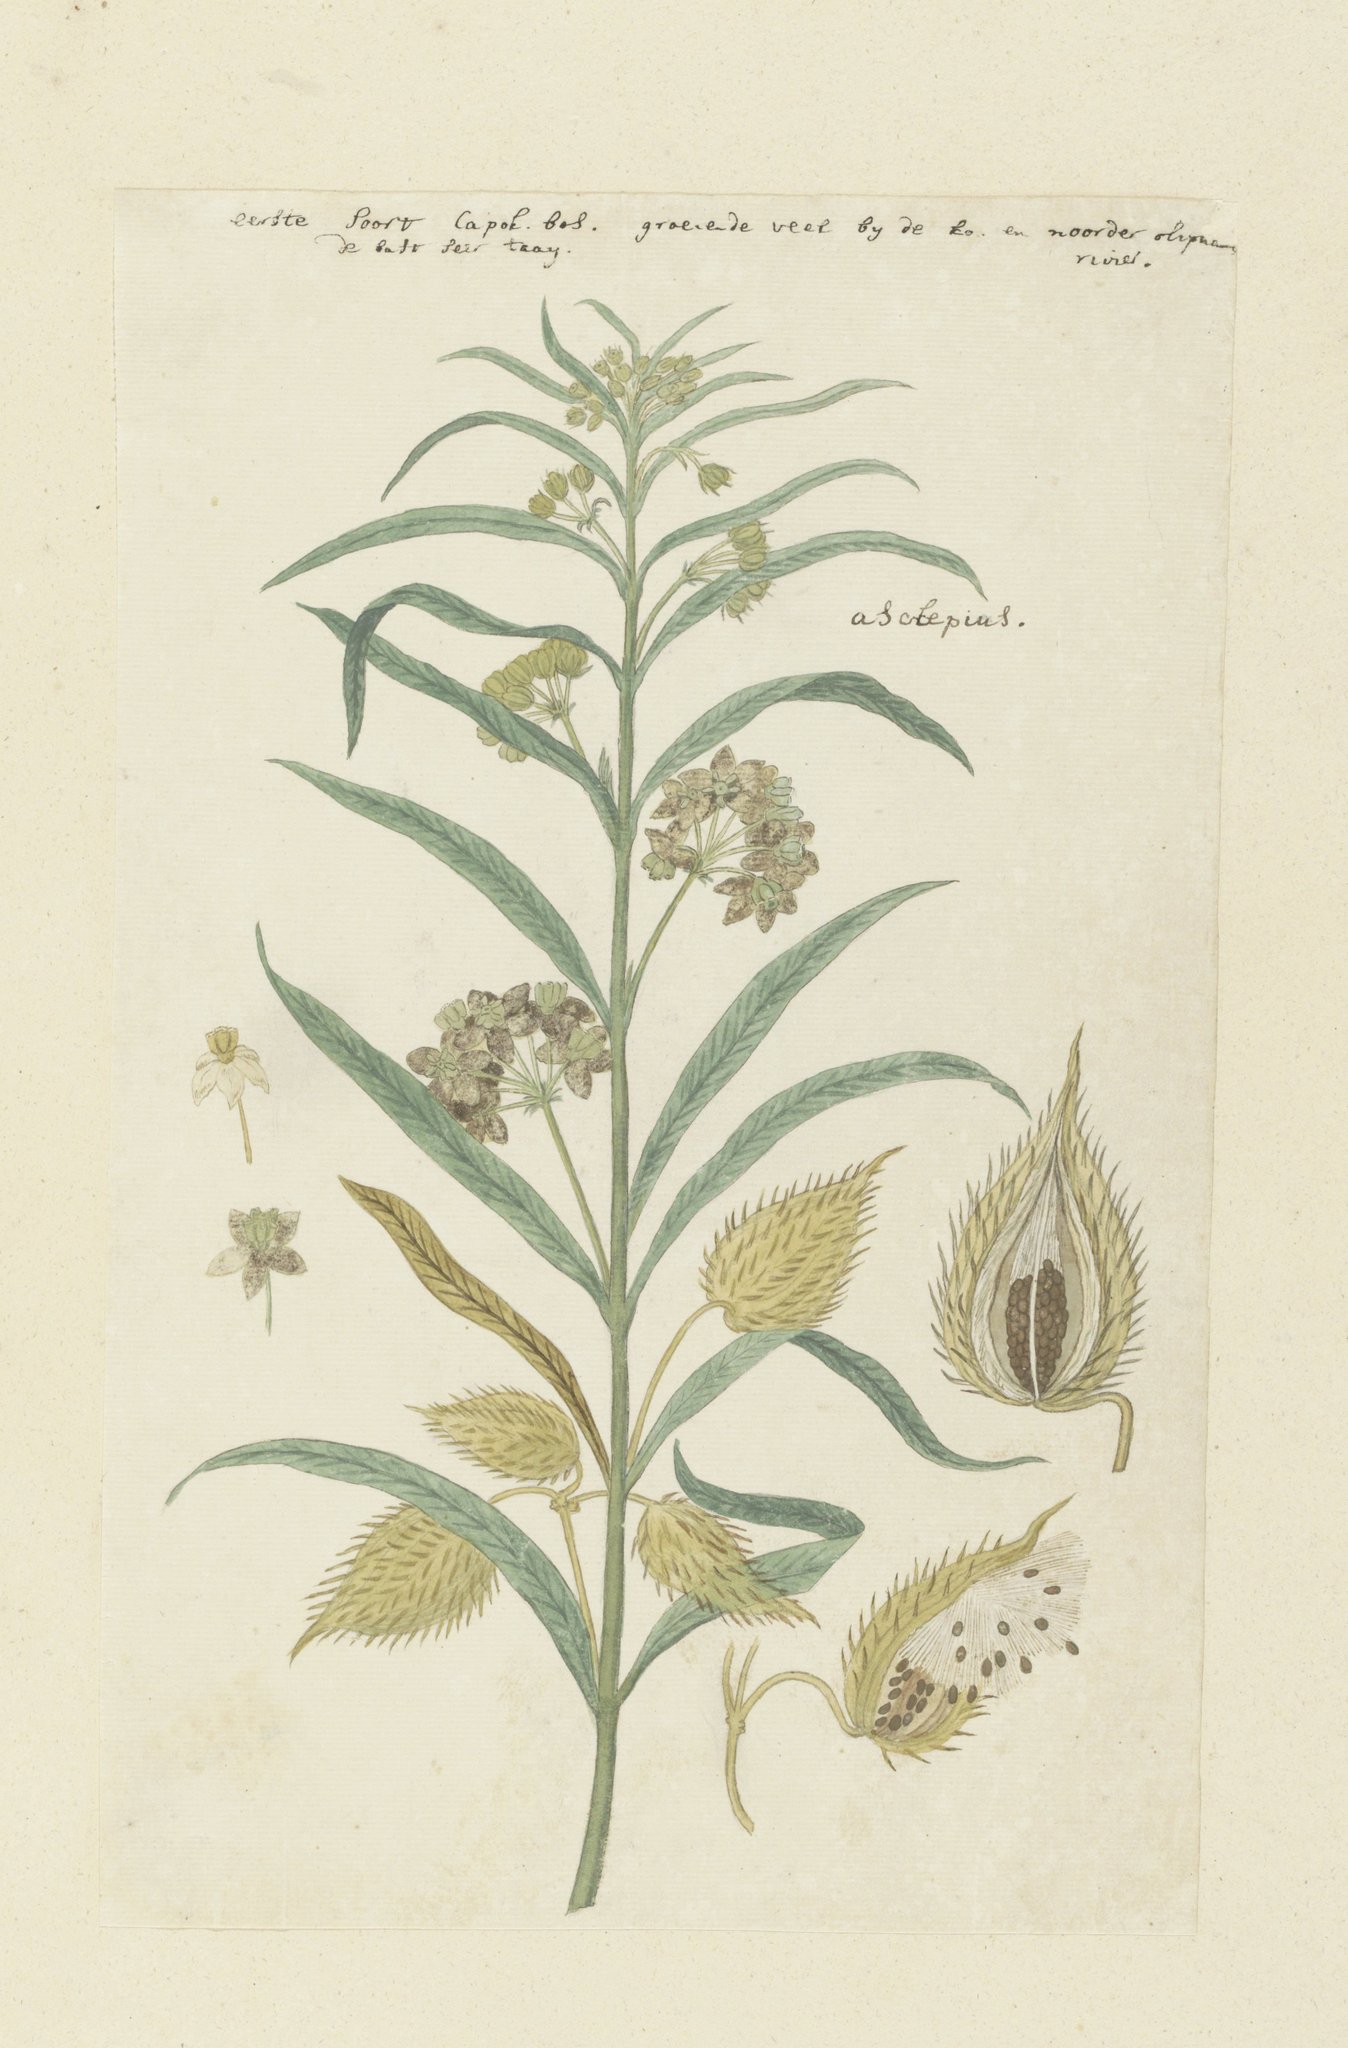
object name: album leaf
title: Gomphocarpus fruticosus, formerly Asclepias fruticosa (Tennis-ball milkweed)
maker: robert jacob gordon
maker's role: draughtsman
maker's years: 1743-1795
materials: chalk, ink, paper, pencil, watercolor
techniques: brush, pen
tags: plants; vegetation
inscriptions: annotation: ‘eerste Soort Capok. bos. groeiende veel bij de ko. en noorder Oliphants/rivier. / de bast seer taaij. /asclepias.’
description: De tekening is gemaakt tijdens Gordon's tweede of derde expeditie door de Kaapprovincie, van augustus 1778 tot januari 1780, door het noordwestelijke deel. Sommige (soort)namen kunnen zijn gewijzigd, gezien reorganisatie in plantentaxonomie gedurende de afgelopen jaren.